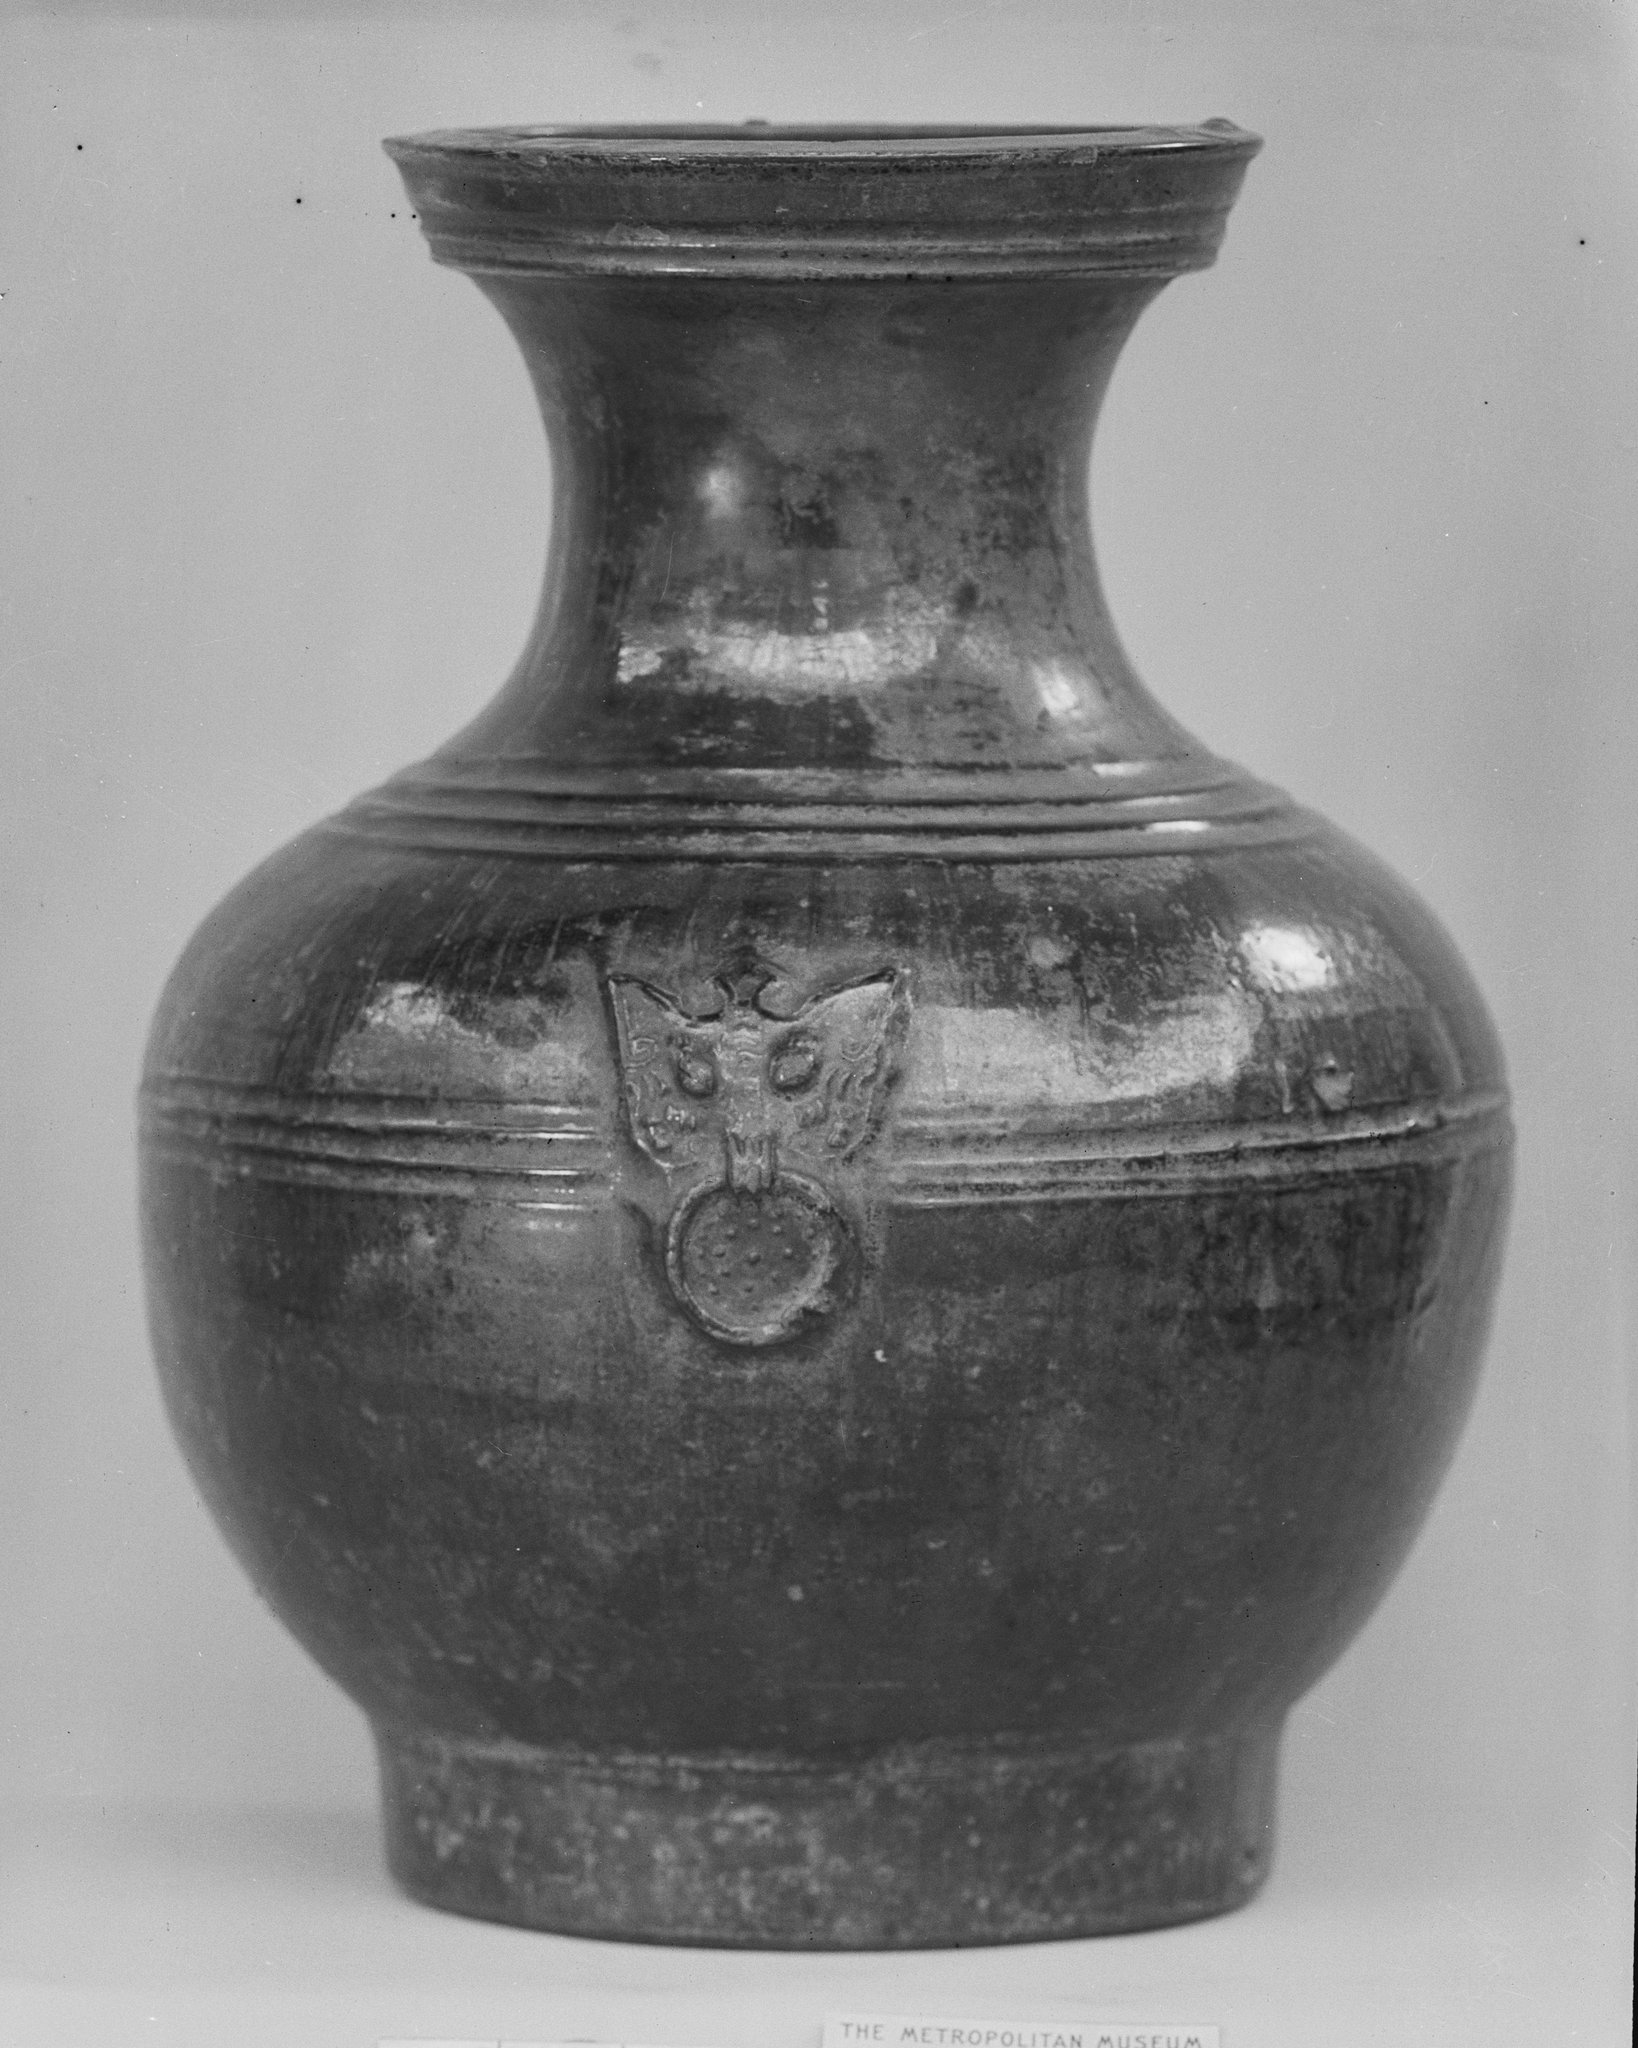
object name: jar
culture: chinese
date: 100 BCE-100 CE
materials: earthenware, glaze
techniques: relief